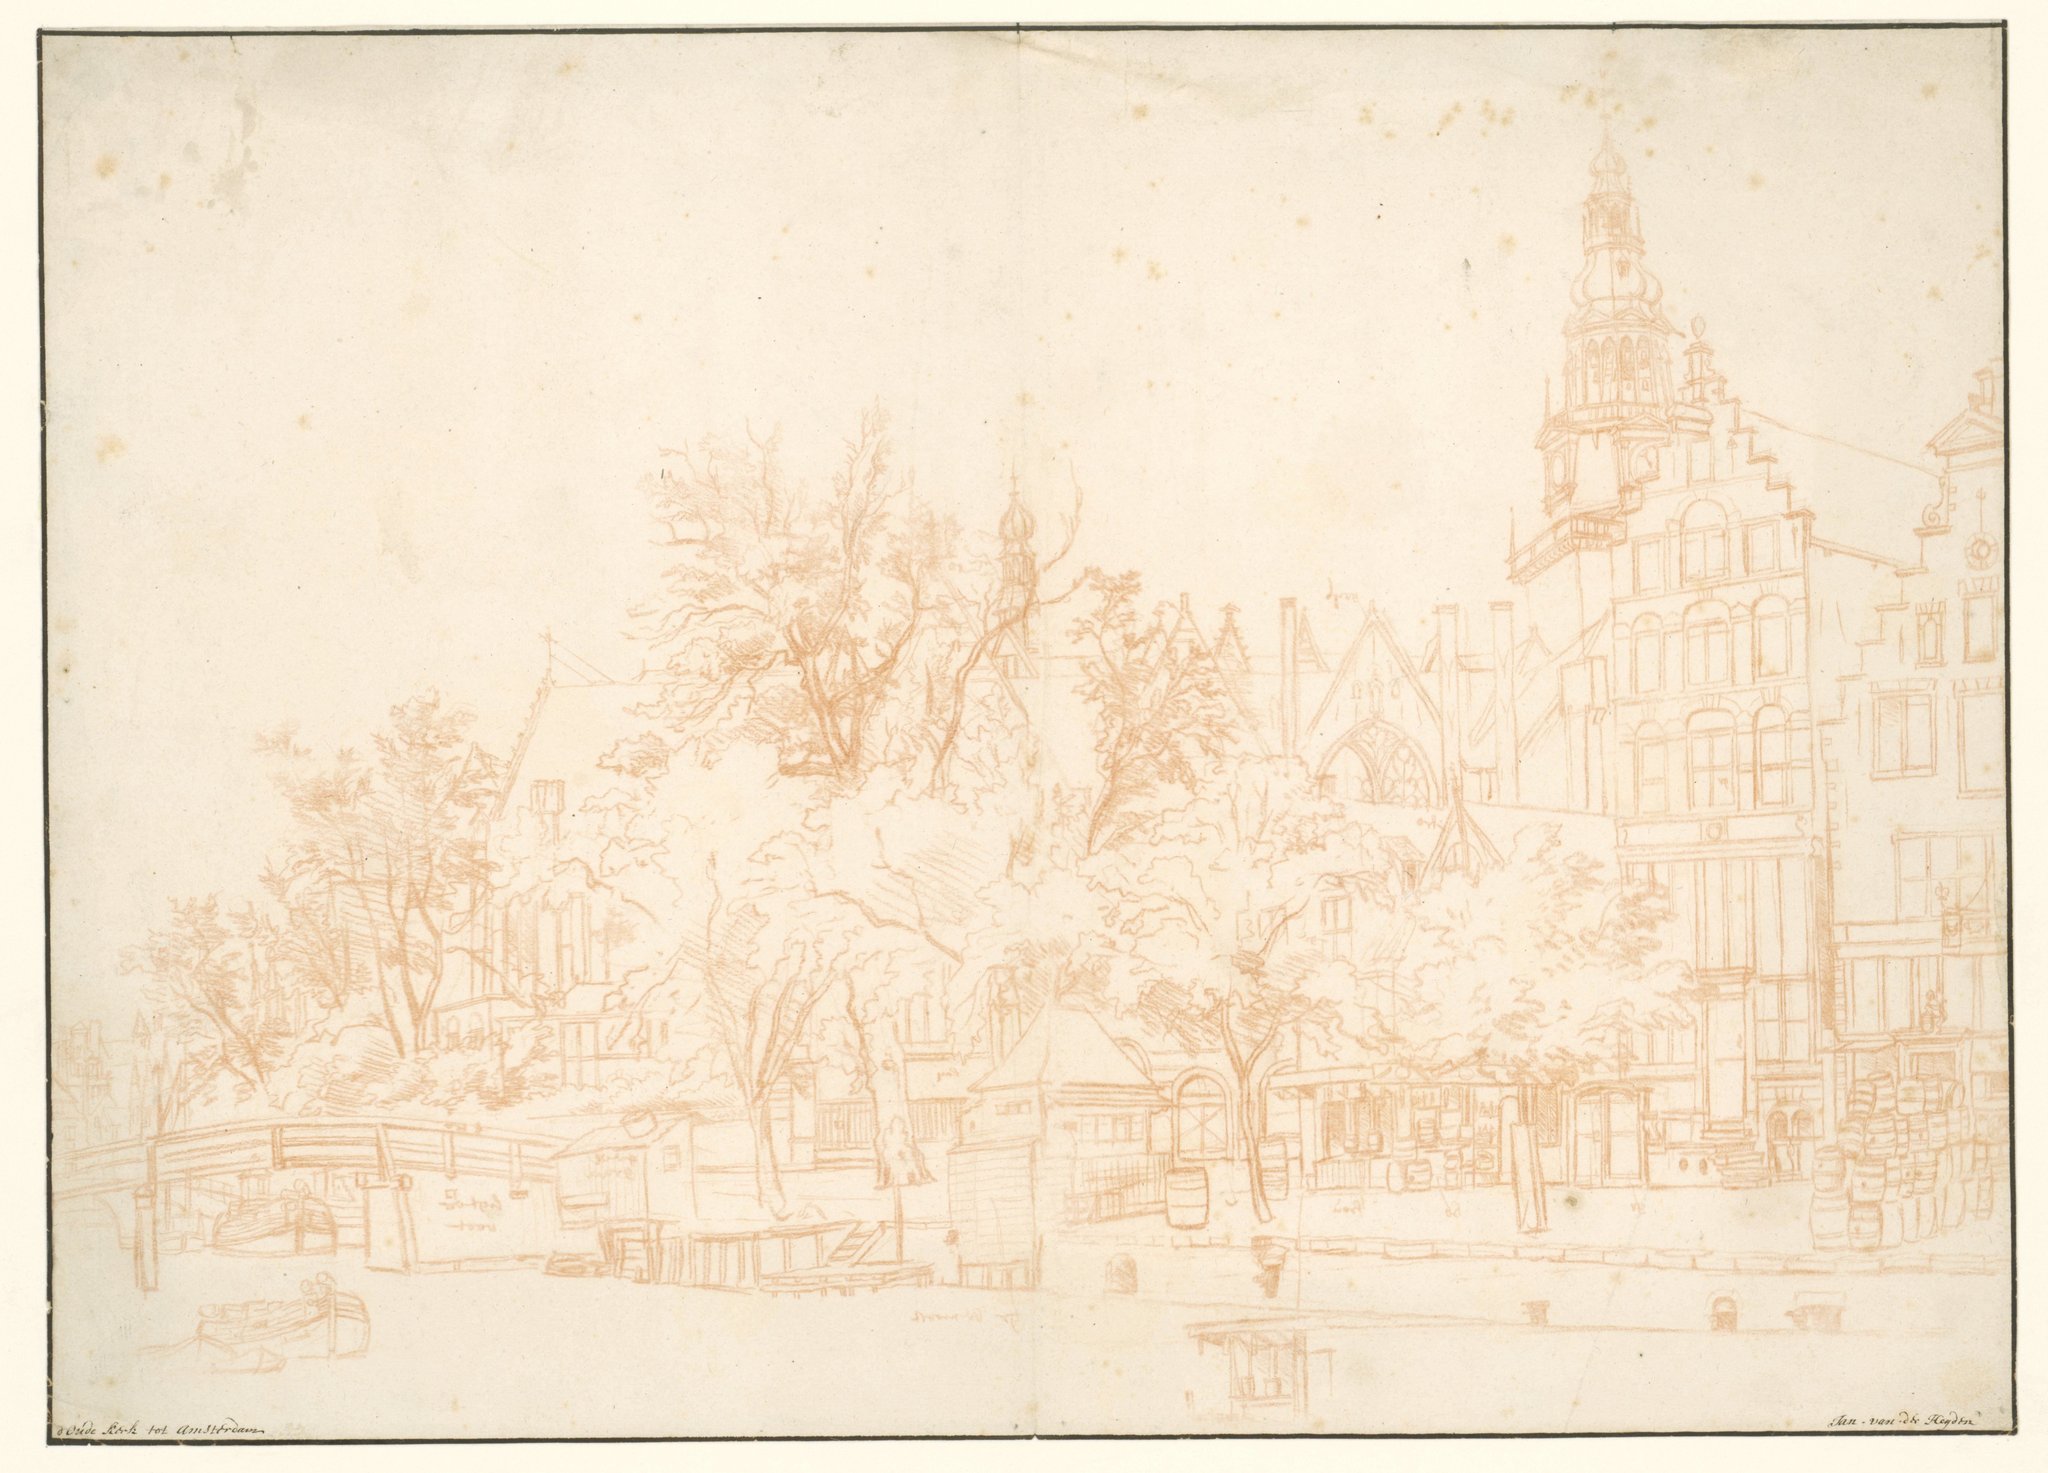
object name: design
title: Huizen op de Herengracht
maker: jan van der heyden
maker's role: draughtsman, painter, print maker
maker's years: 1637-1712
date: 1683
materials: ink, paper, pencil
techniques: pen, drawing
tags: urban housing, ruin of a building ~ architecture, canals, waters (in city)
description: Enige huizen op de Herengracht die getroffen werden door de brand op 25 en 26 april 1683. Ontwerp voor een prent.